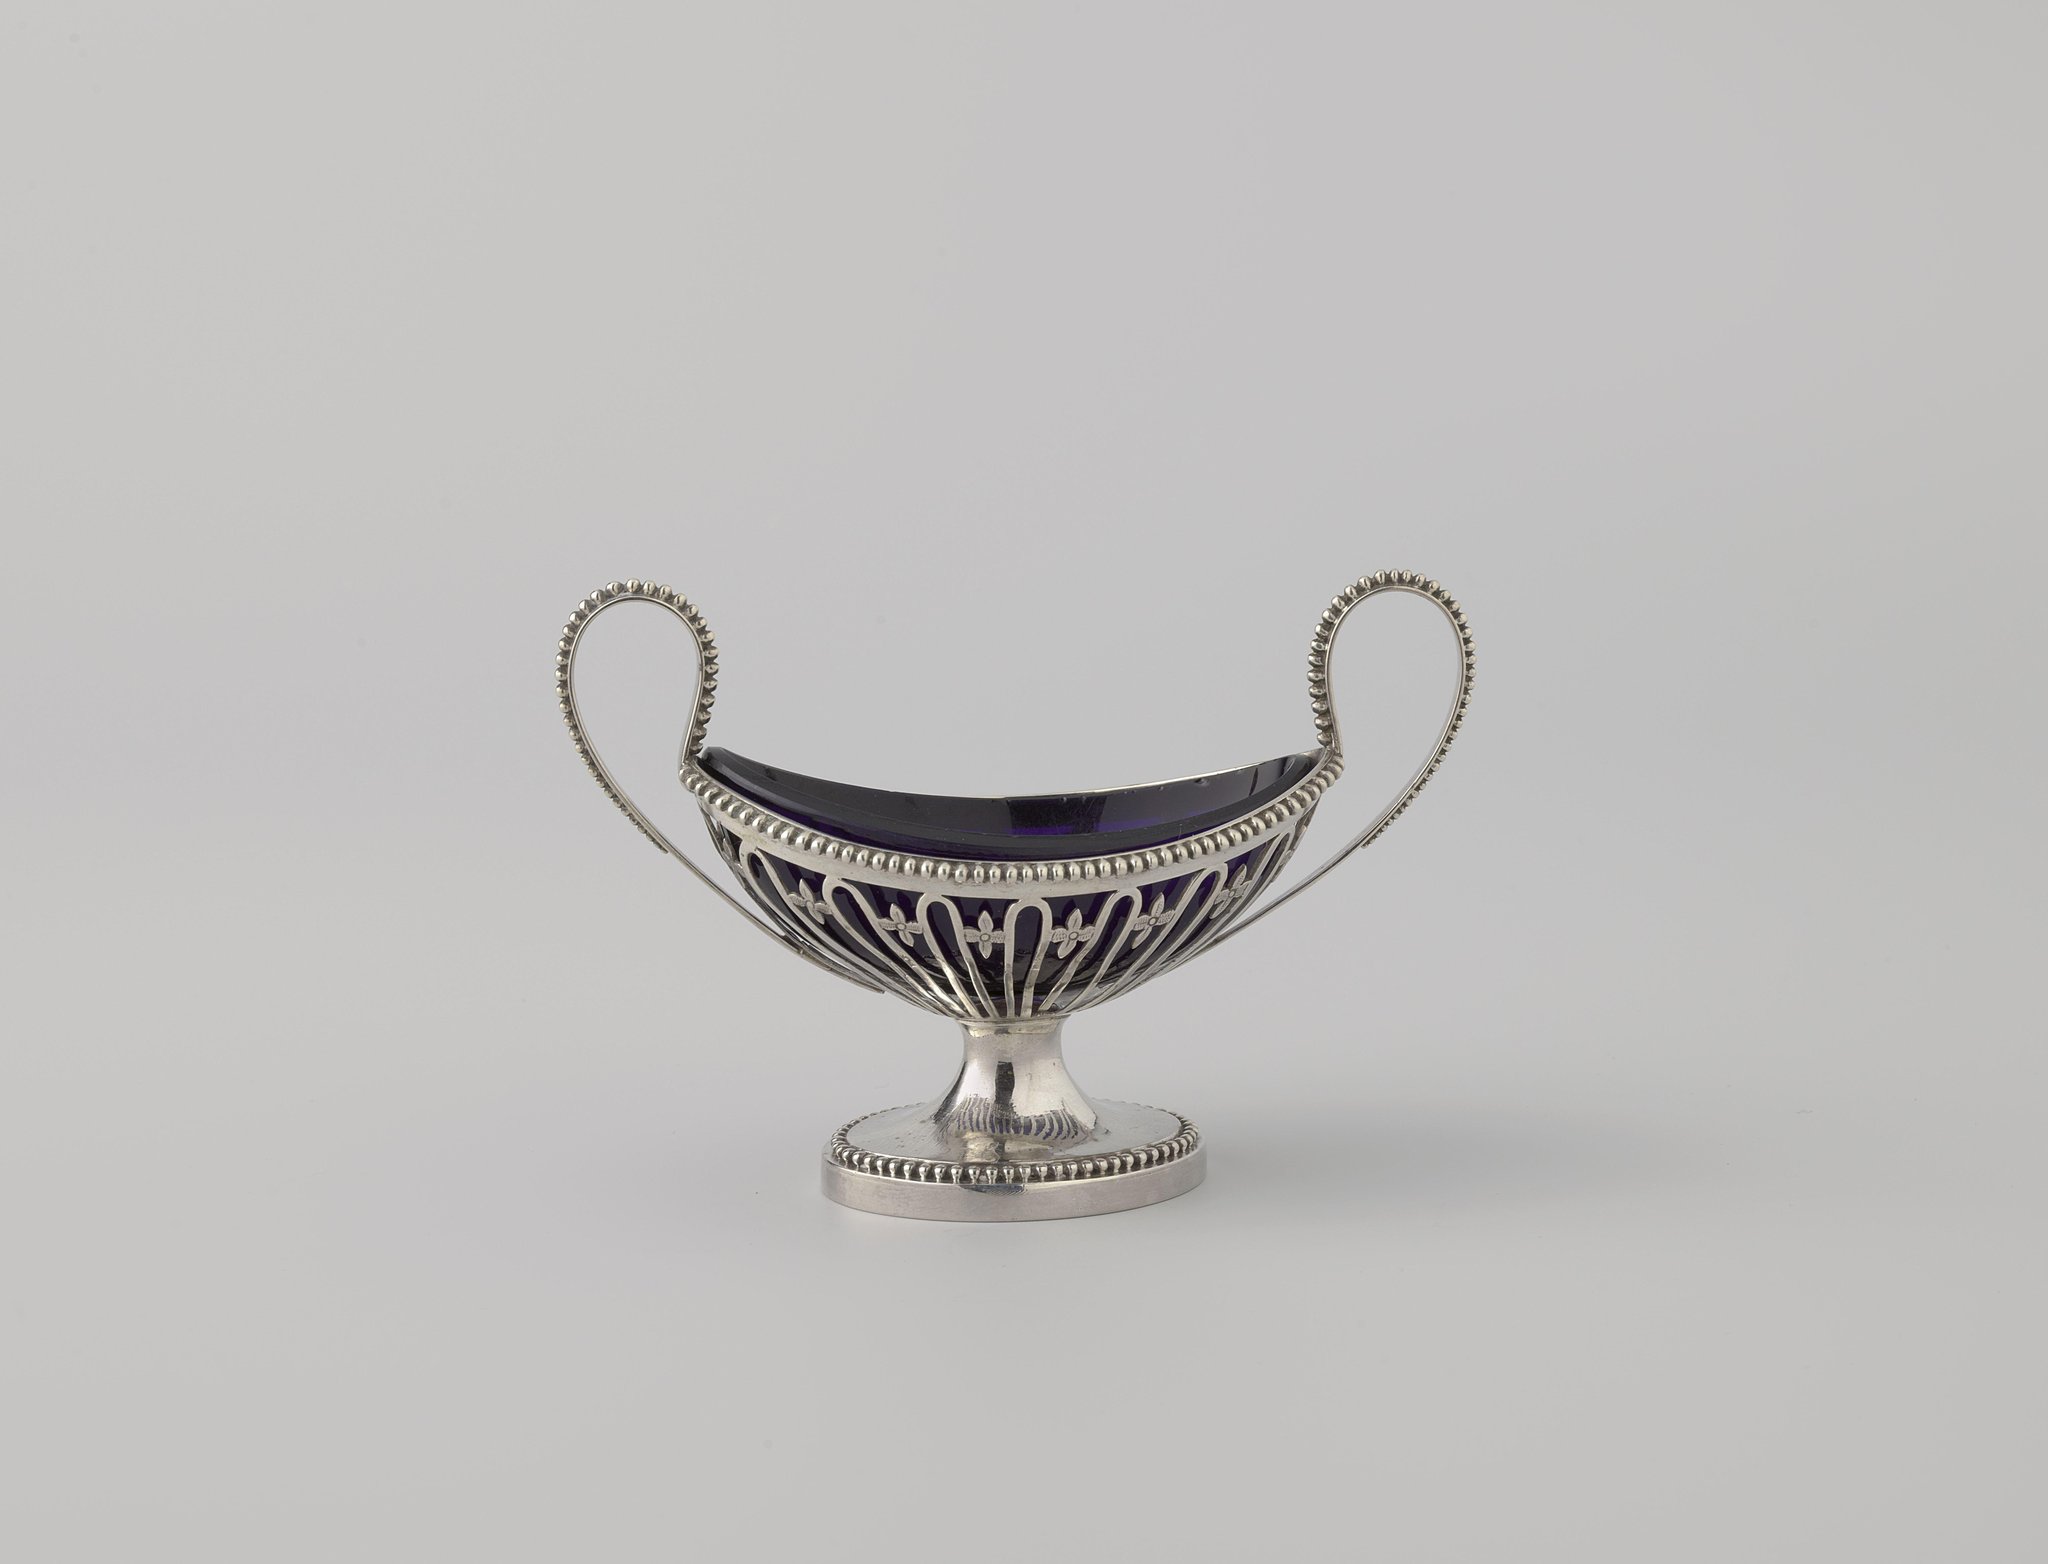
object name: salt condiment vessel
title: Zoutvat, spitsovaal, met opengewerkte wand met parellijsten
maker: nathanael teuter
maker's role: silversmith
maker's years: 1767-1831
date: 1805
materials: silver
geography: amsterdam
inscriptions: maker's mark, duty mark, alloy mark, town mark, date letter: ‘W’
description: De spits ovale, gewelfde vaten (A, B,C en D), die aan de zijkanten iets verhoogde wanden hebben, rusten op een ovale, zich naar boven sterk verjongende voet met een rechtwandige basis. Het lichaam is opengewerkt met afwisselend knerren en rozetten. Rond de voet, rond de bovenrand van het lichaam en over de hoog oplopende, gebogen oren lopen parellijsten. In de vaatjes passen binnenbakjes van blauw glas, waarvan D met krammetjes is hersteld.